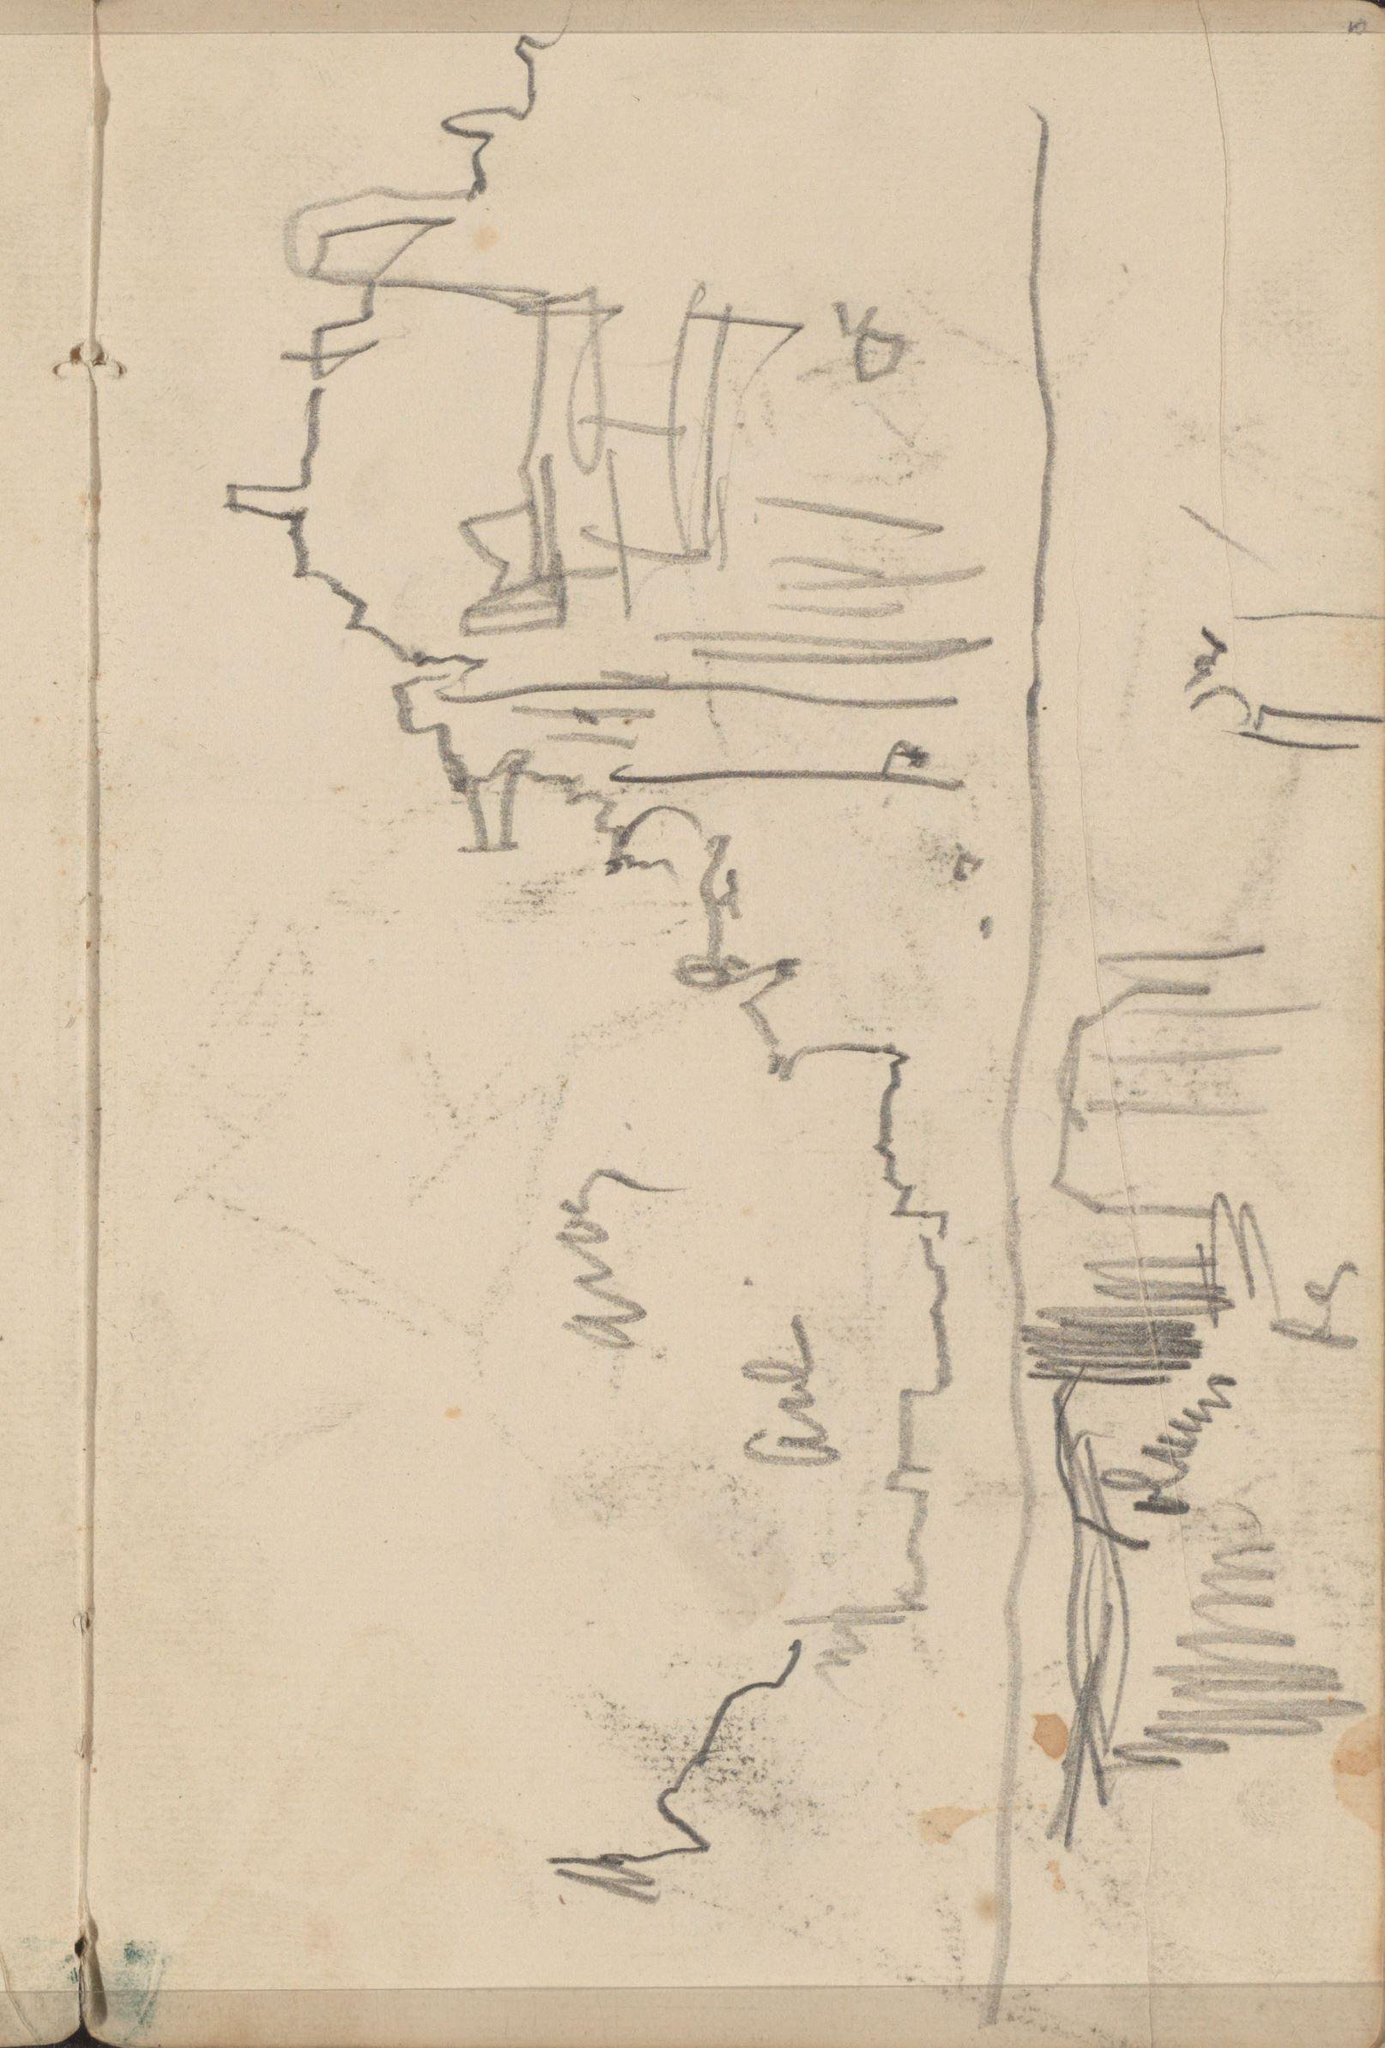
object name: sketchbook leaf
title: Gezicht op een brug, mogelijk de Langebrug over het Rokin te Amsterdam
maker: george hendrik breitner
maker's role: draughtsman, painter, print maker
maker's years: 1857-1923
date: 1886-1903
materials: paper, pencil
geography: amsterdam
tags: bridge in city across river, canal, etc., civic architecture; edifices; dwellings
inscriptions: kleurnotitie, handgeschreven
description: Pagina 10 uit een schetsboek met 15 bladen.